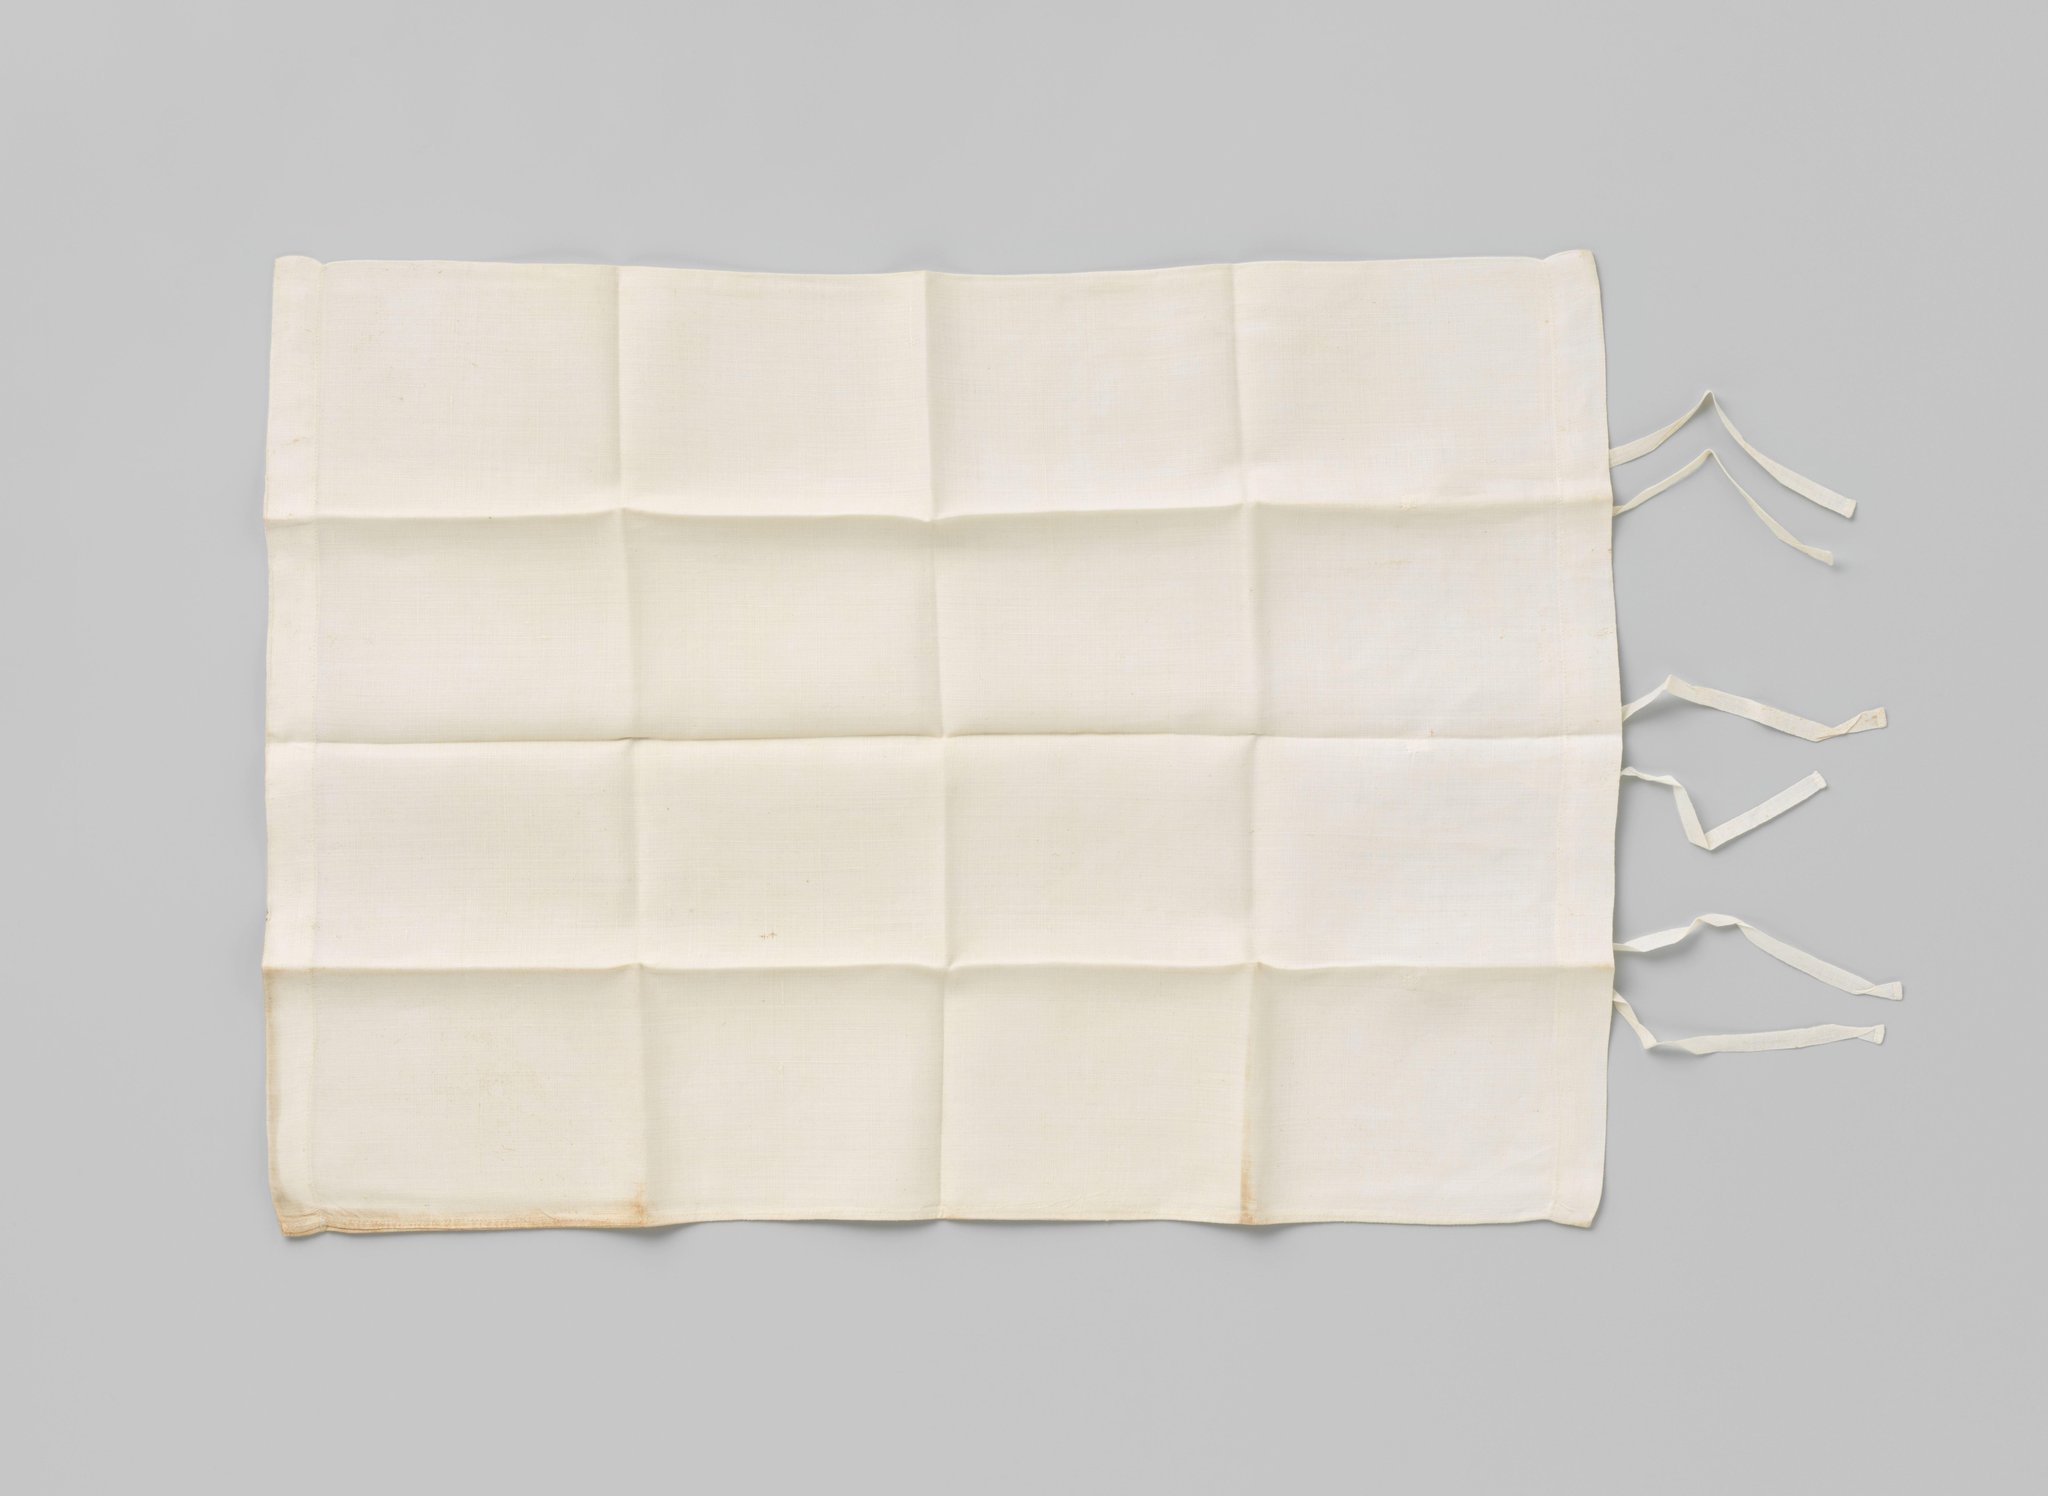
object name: lendensloop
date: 1820-1870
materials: linen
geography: northern netherlands